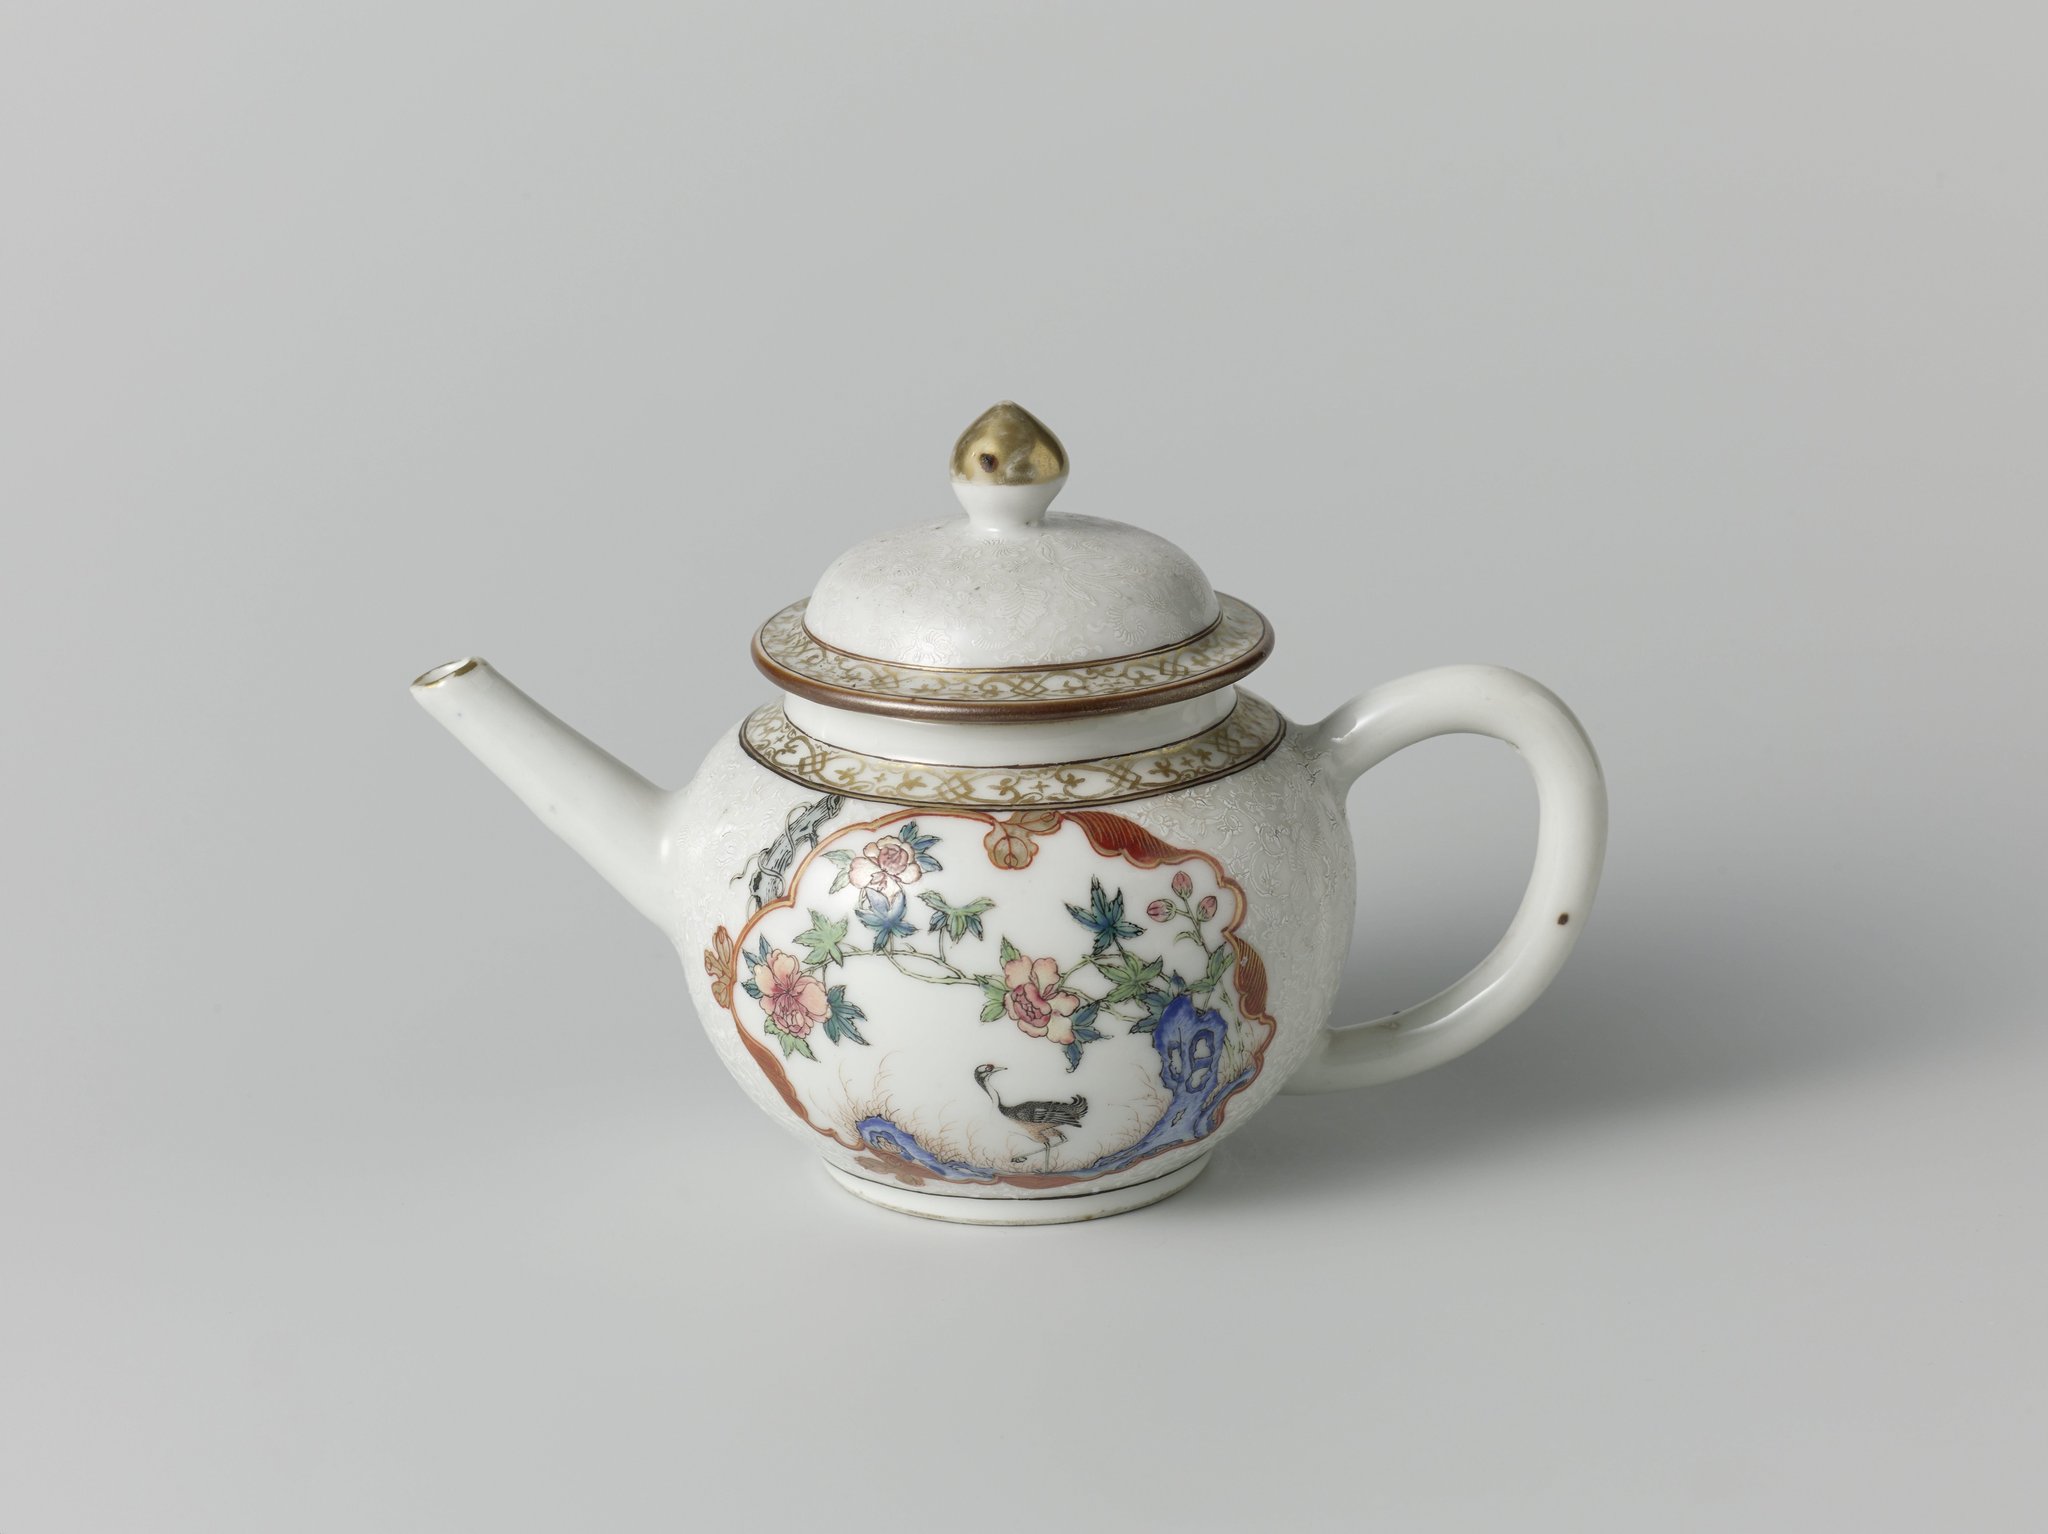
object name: teapot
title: Teapot with a crane near a peony plant and rock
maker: Anonymous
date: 1725-1749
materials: glaze, gold, paint, porcelain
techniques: firing, gilding, turning, vitrification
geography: china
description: Gedecoreerd in emails, goud en bianco sopra bianco met vogels en bloeiende planten.